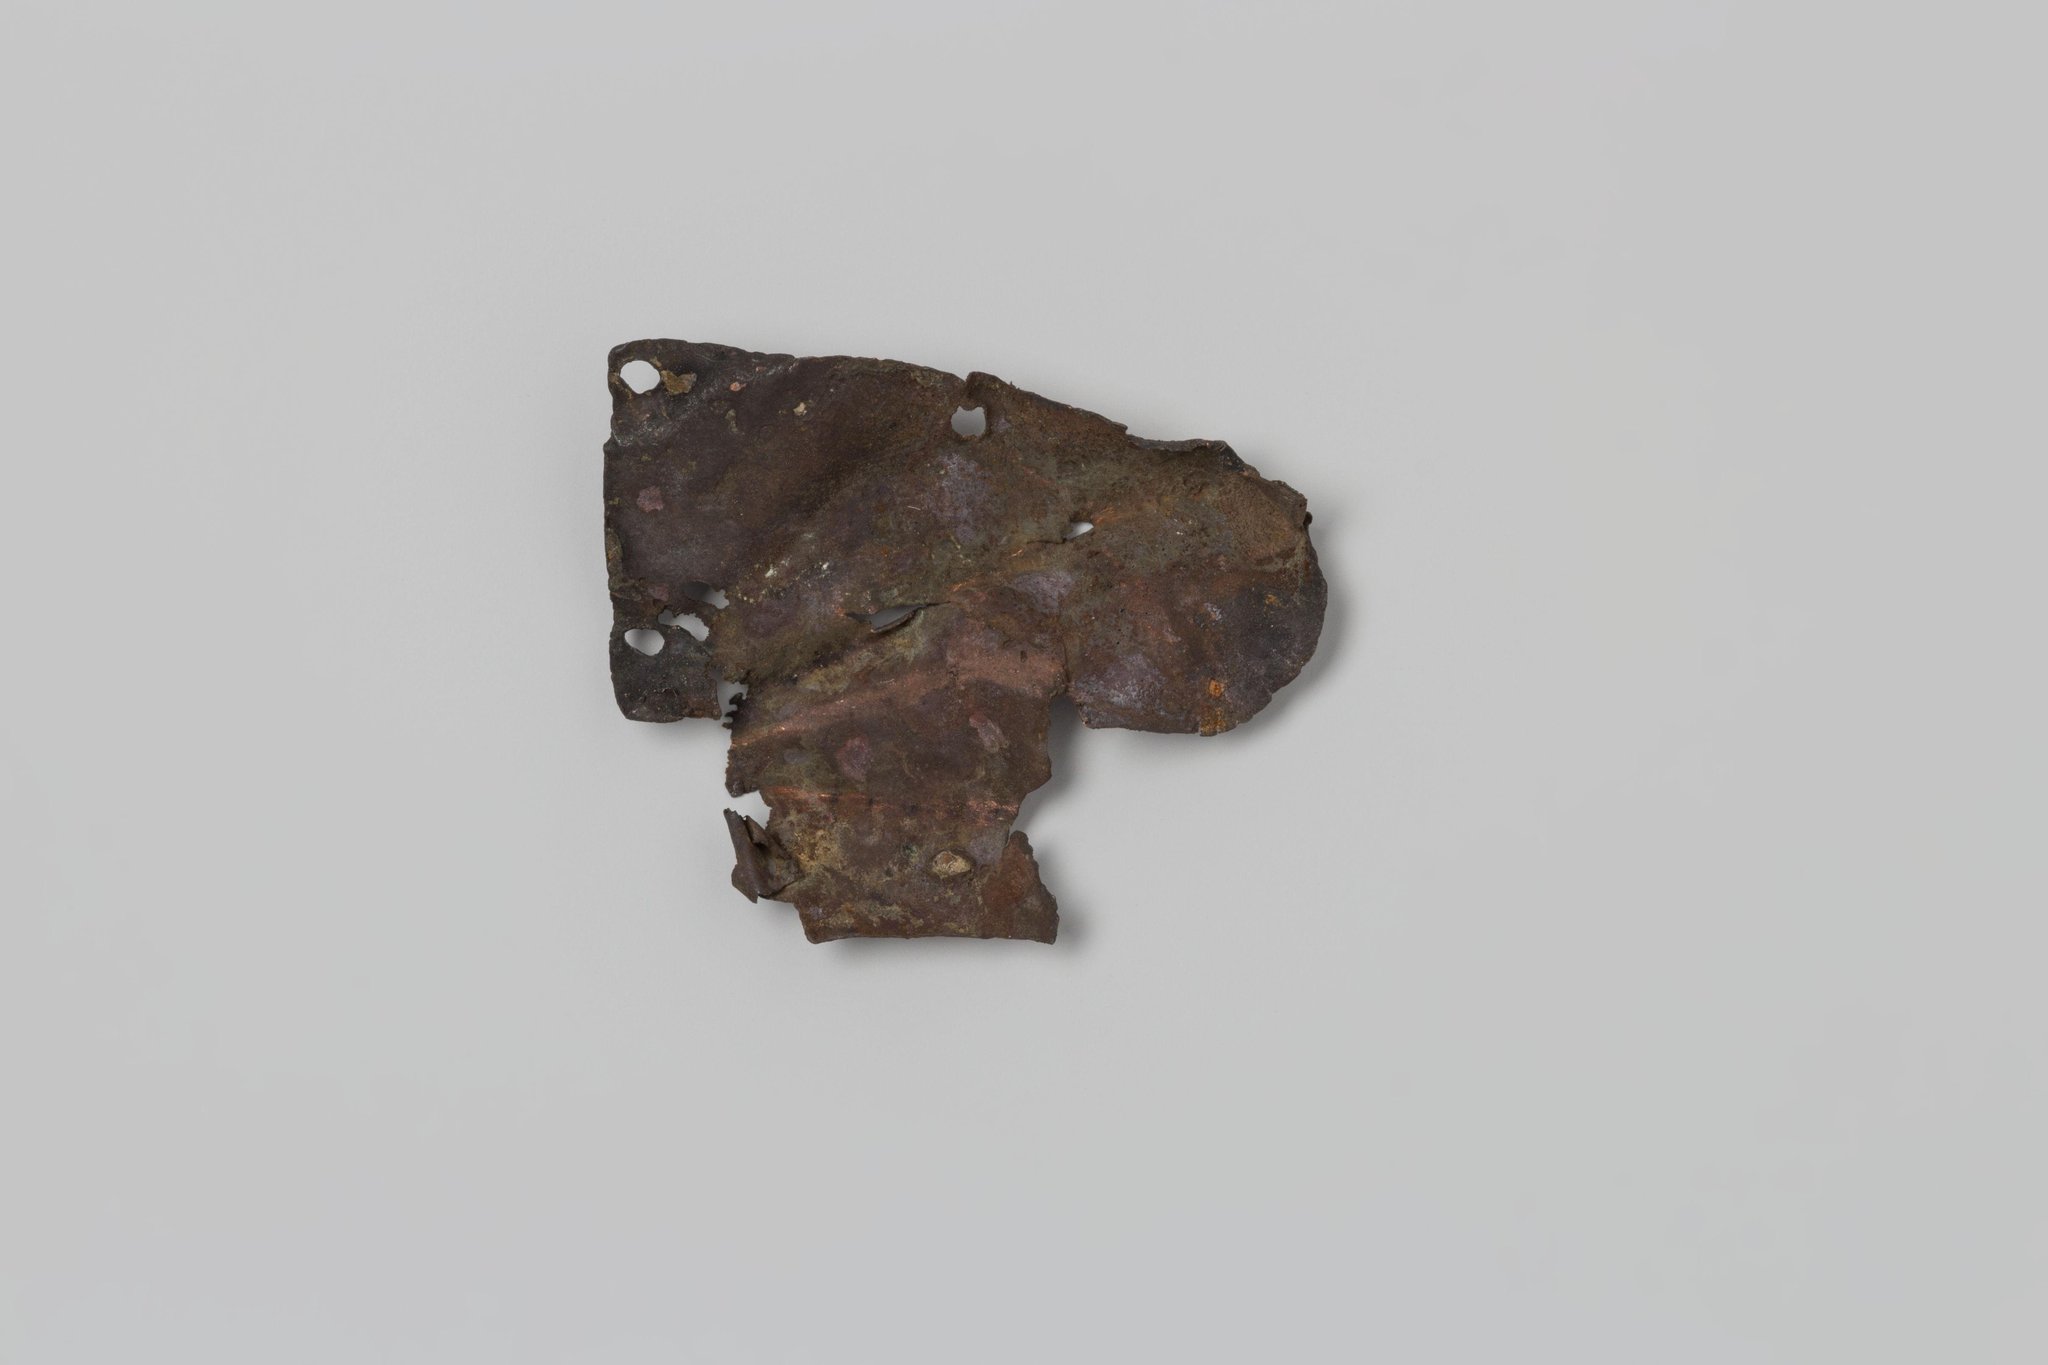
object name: musket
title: Fragment kolfplaat van een musket uit het wrak van de Oost-Indiëvaarder Hollandia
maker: Anonymous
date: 1700-1743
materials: copper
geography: netherlands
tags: verenigde oostindische compagnie, hollandia (schip), annet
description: Musket, butt-plate; squashed, fragm id. NG 1979-207H3071.